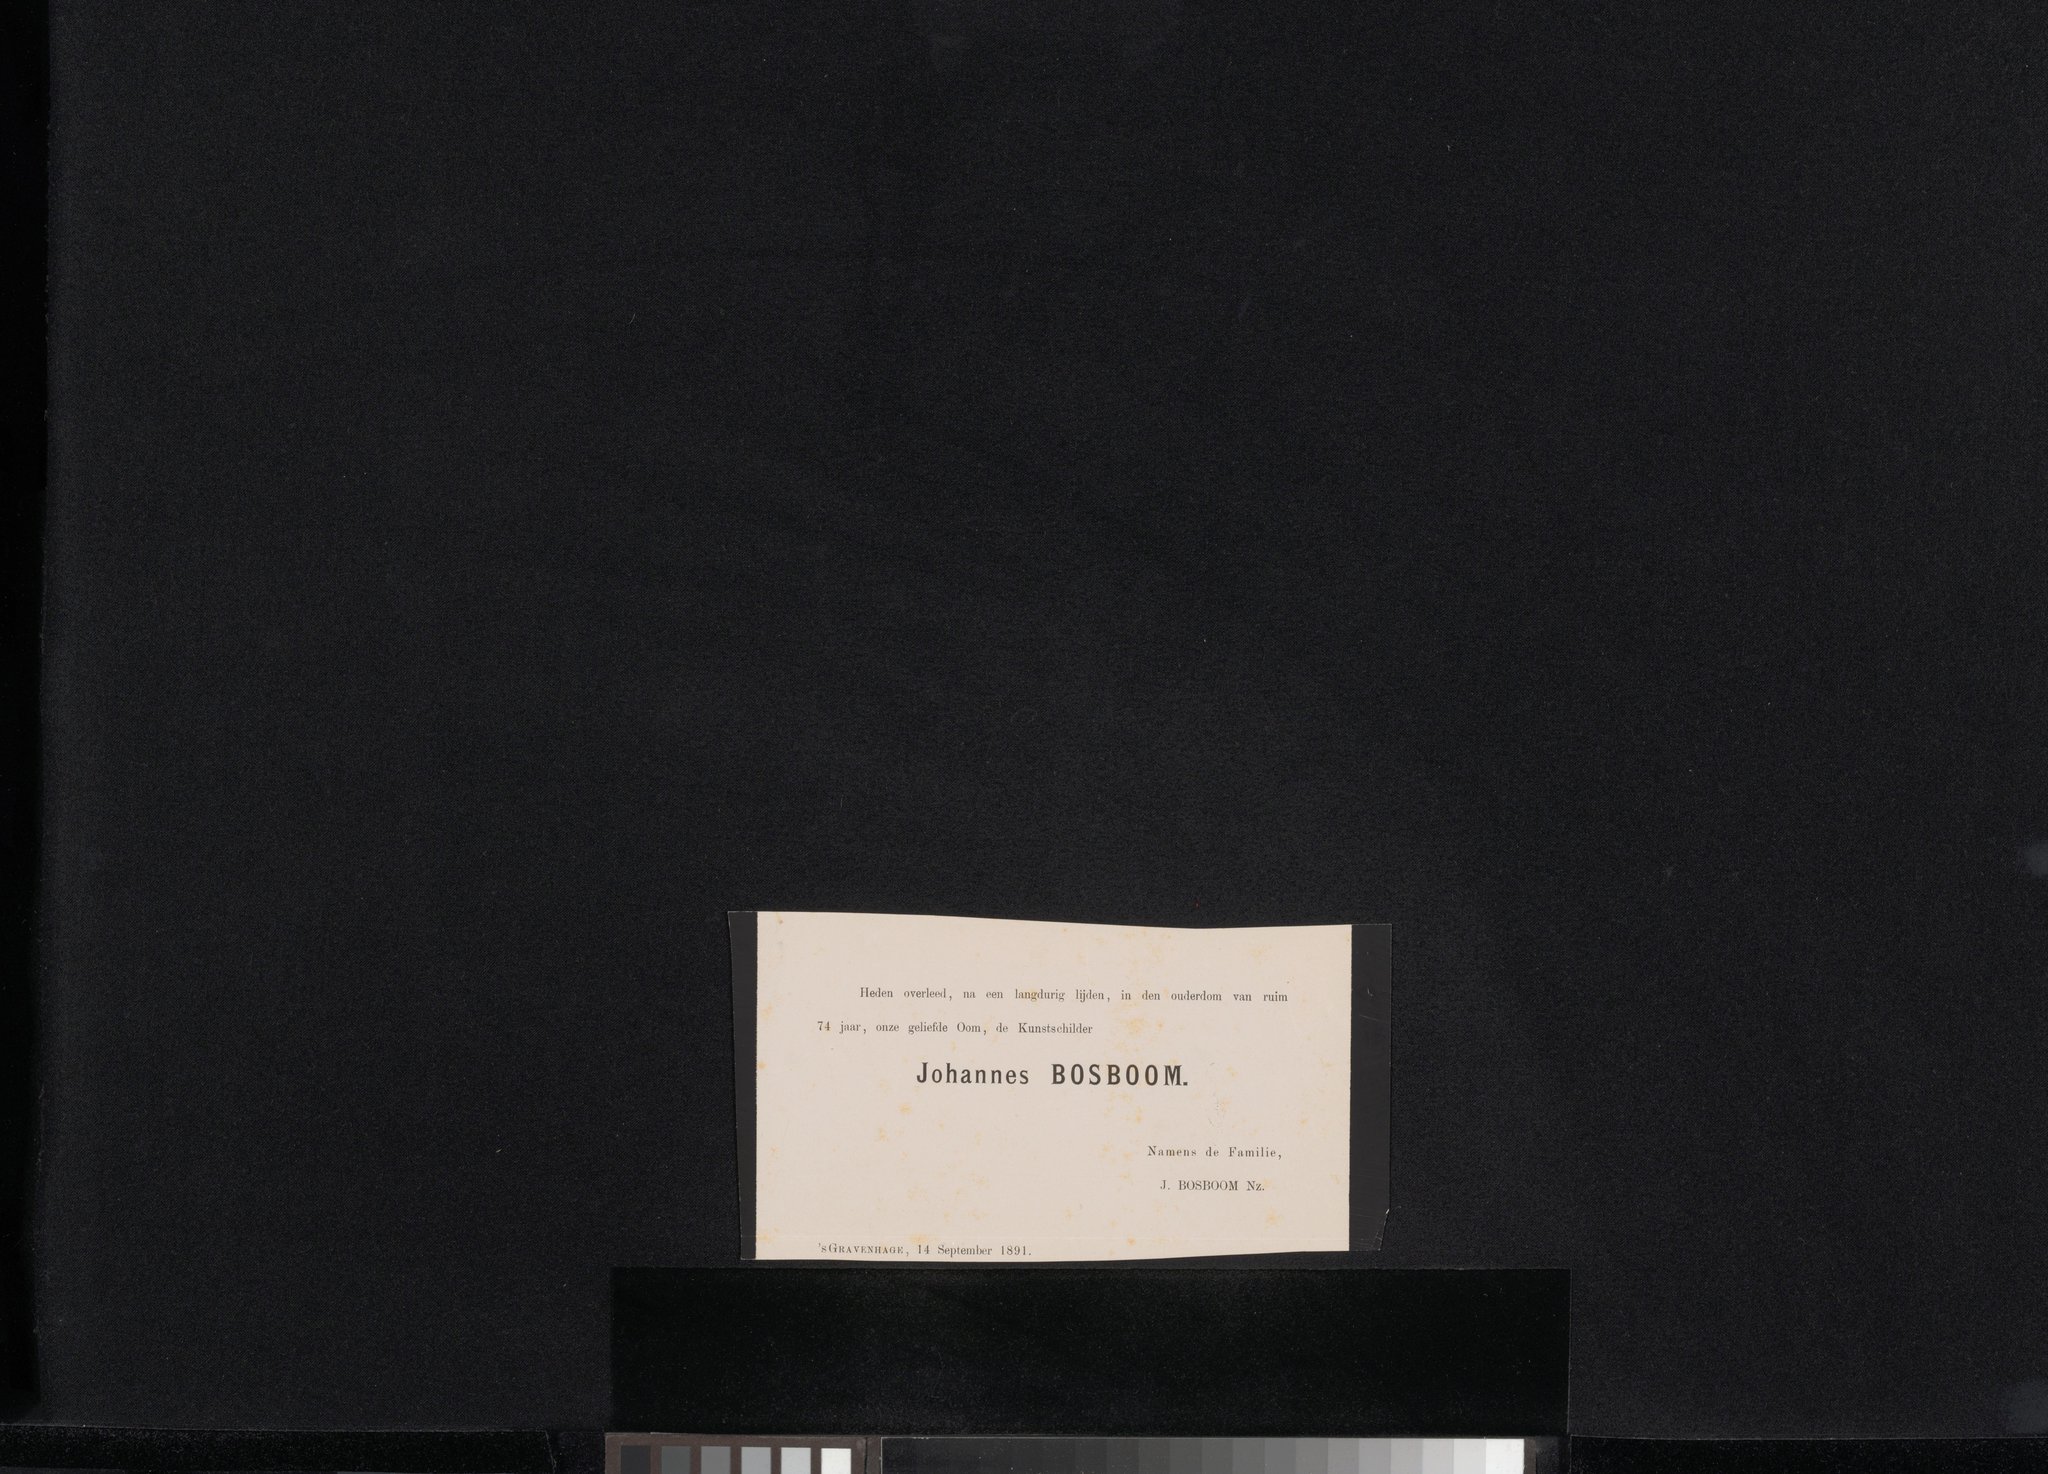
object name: overlijdensbericht, overlijdensadvertentie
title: Overlijdensbericht betreffende Johannes Bosboom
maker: Anonymous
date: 1891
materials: paper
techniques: printing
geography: the hague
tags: the hague, painter, print maker, draughtsman, johannes bosboom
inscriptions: collector's mark: Lugt 2228